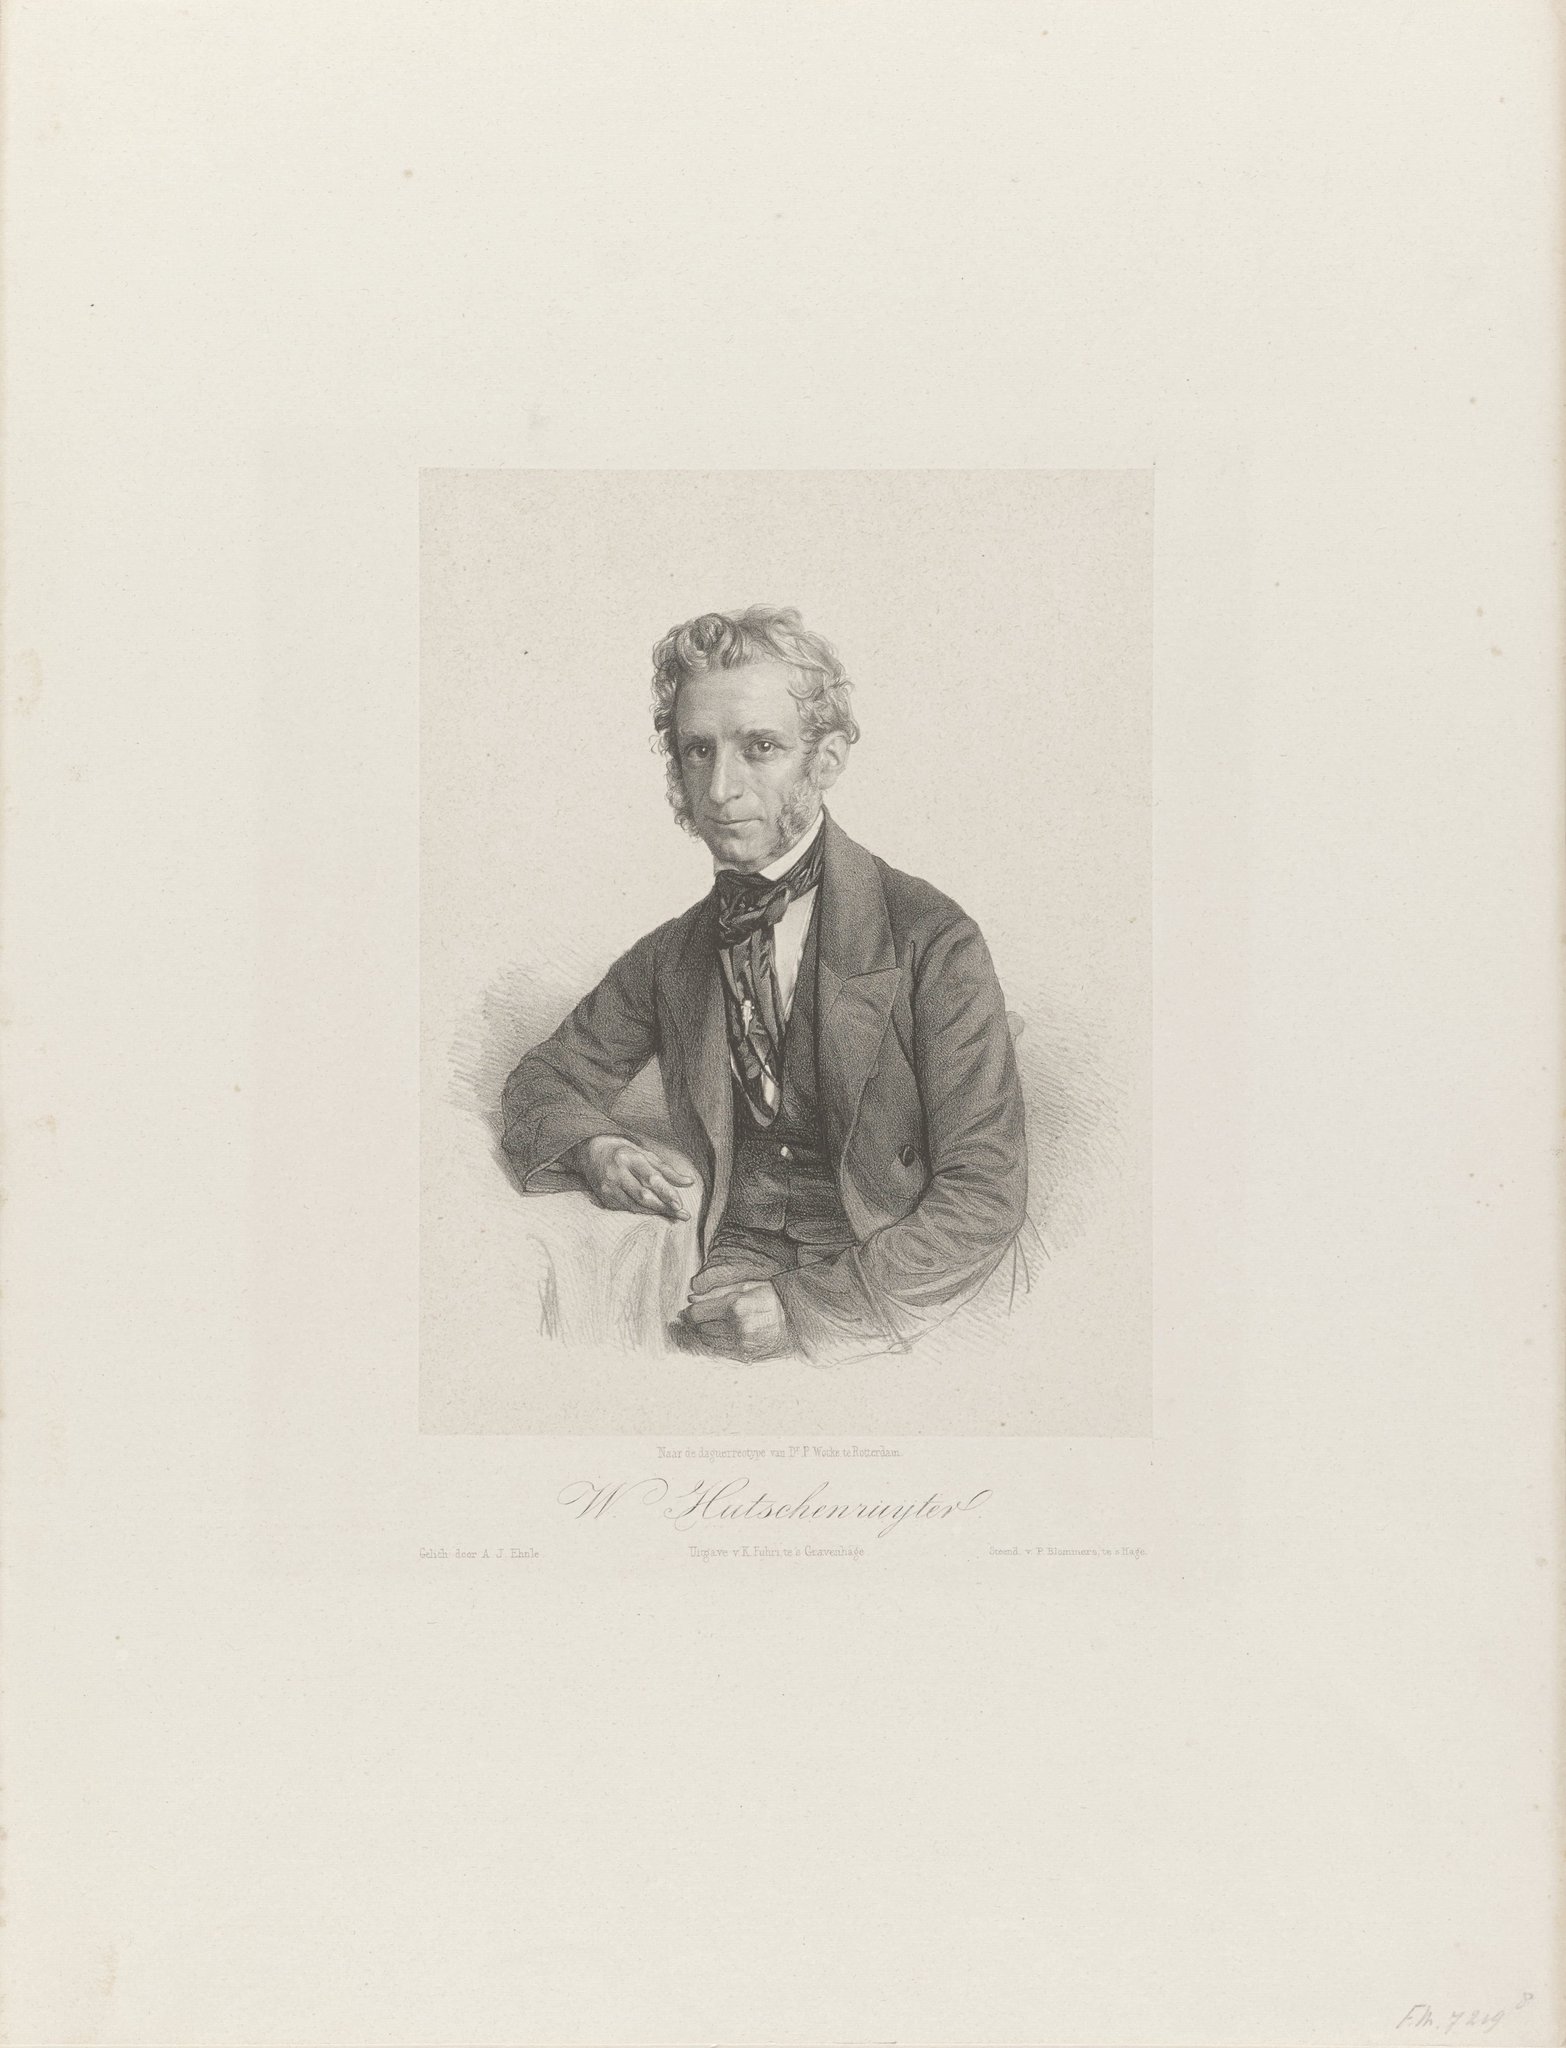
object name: print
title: Portret van W. Hutschenruyter, 1854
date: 1855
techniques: printmaking, lithograph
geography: the hague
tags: rotterdam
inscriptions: collector's mark: Lugt 2228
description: Portret van de dirigent en componist Wouter Hutschenruyter, zittend aan een tafel, 1854. Onderdeel van een serie van twaalf portretten naar daguerrotypieën en twaalf stadsgezichten. Ter gelegenheid van het Muziekfeest ter viering van het 25-jarige bestaan van de Maatschappij ter Bevordering van Toonkunst in Rotterdam, 12-15 juli 1854.